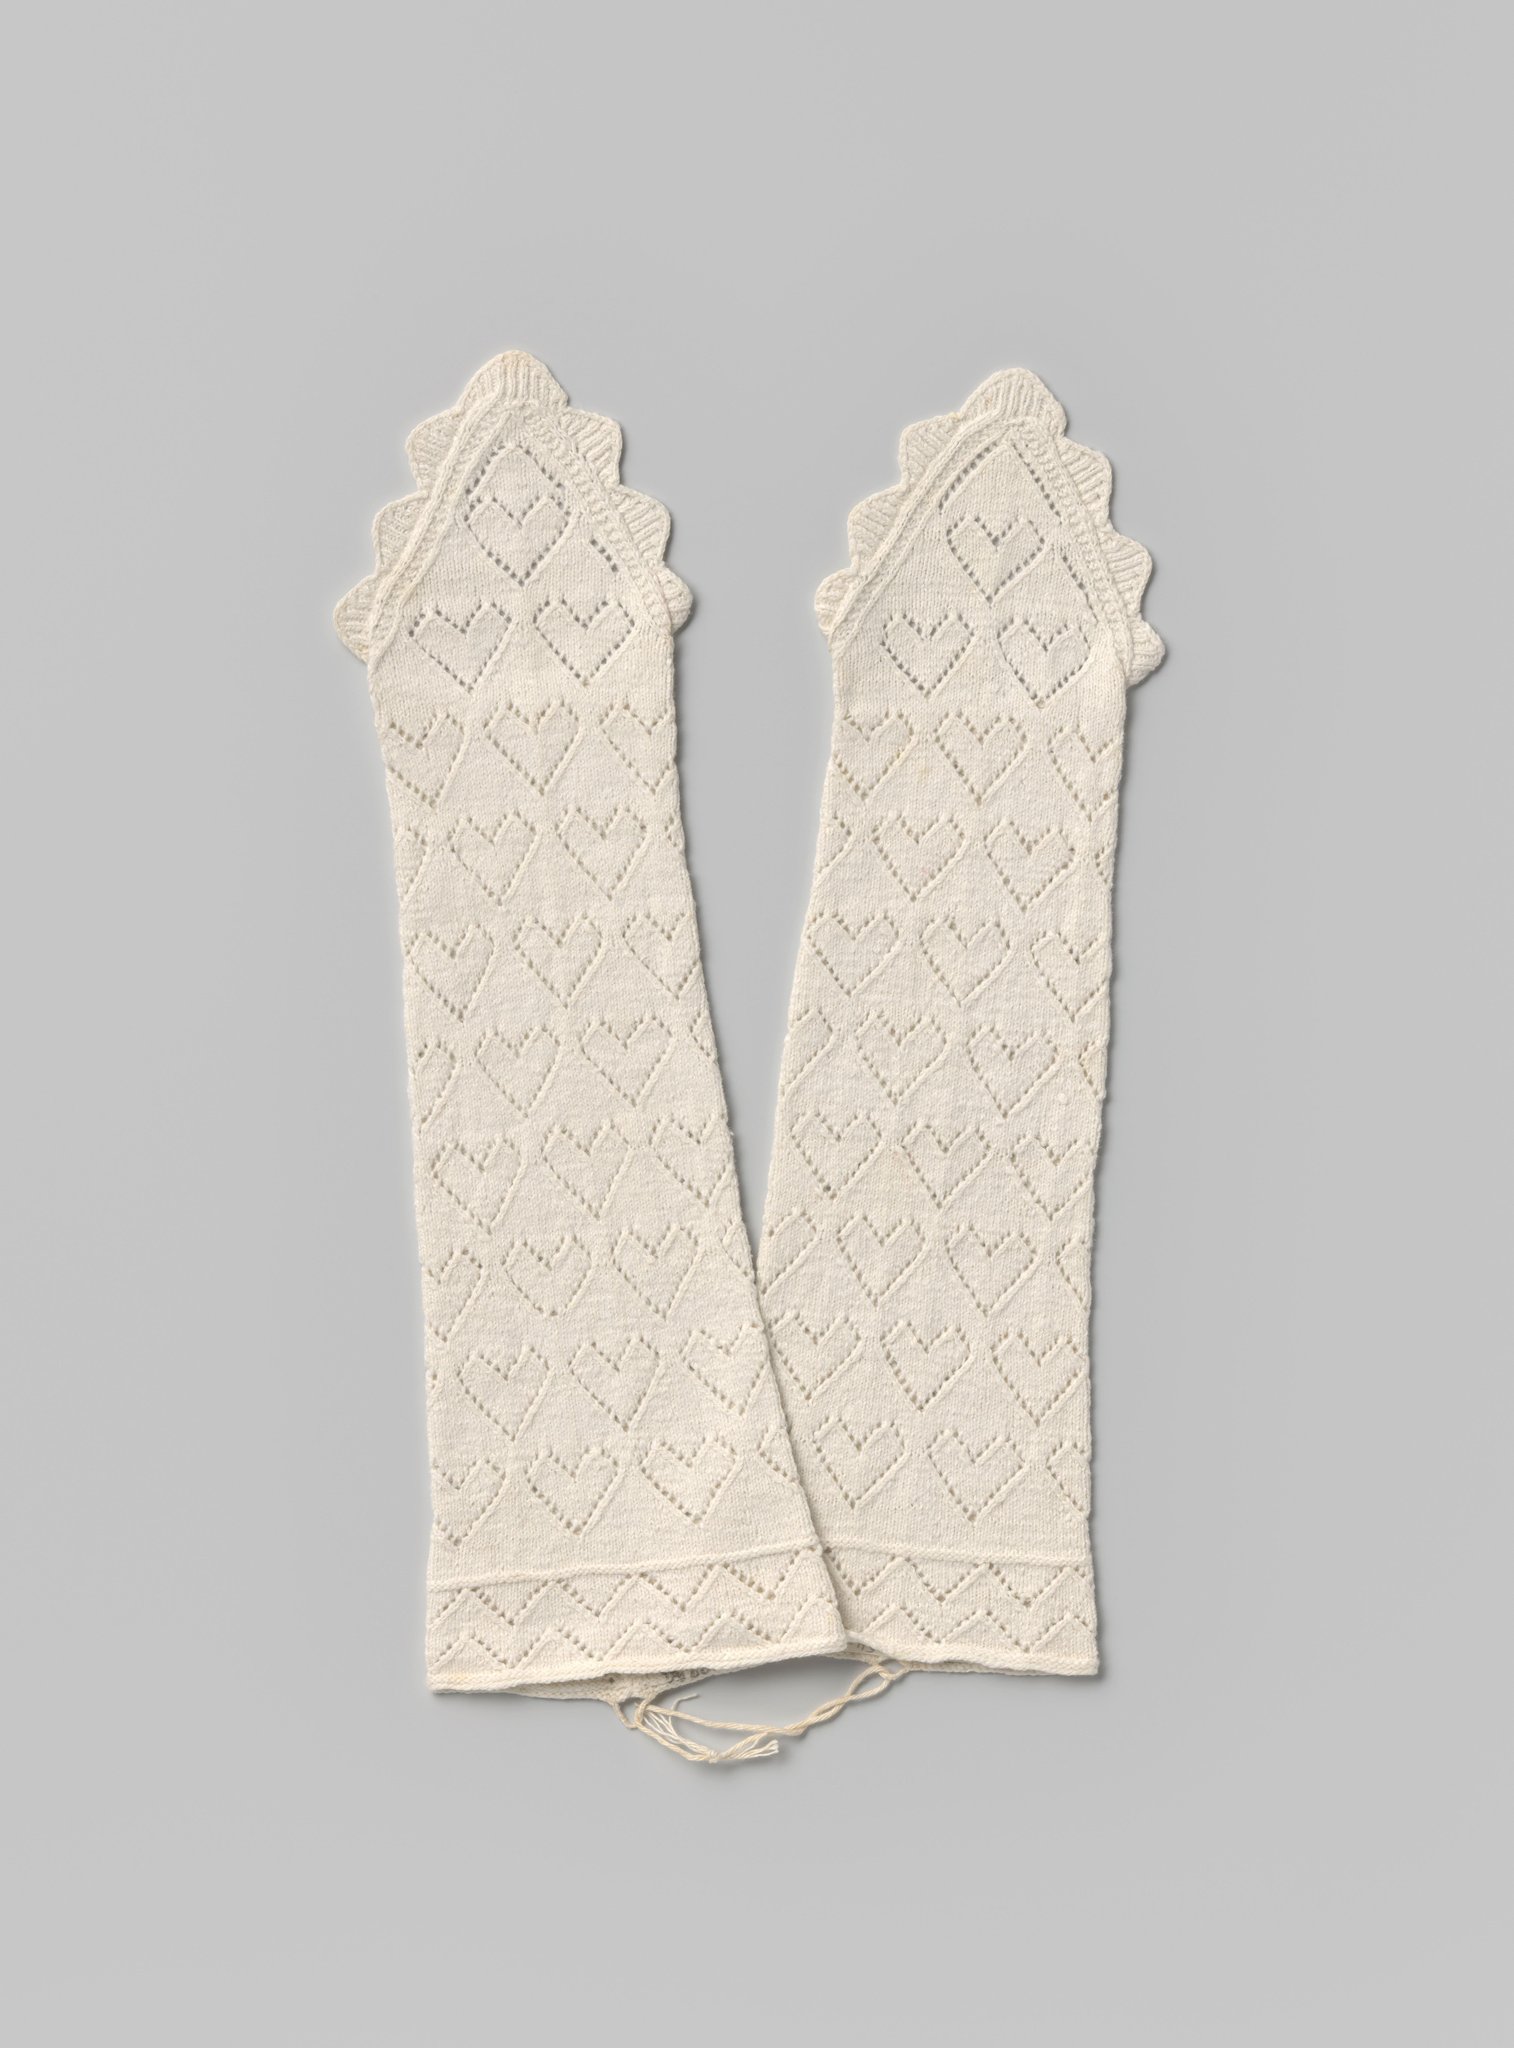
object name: clothing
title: Mitaine van witte gebreide katoen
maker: Anonymous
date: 1750-1800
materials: cotton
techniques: knitting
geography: netherlands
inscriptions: : ‘AEL / G’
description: Mitaine van witte gebreide katoen, met een patroon van rijen hartjes. Over de hand vallende driehoek met zeven schulpen. Gemerkt: AEL / G.